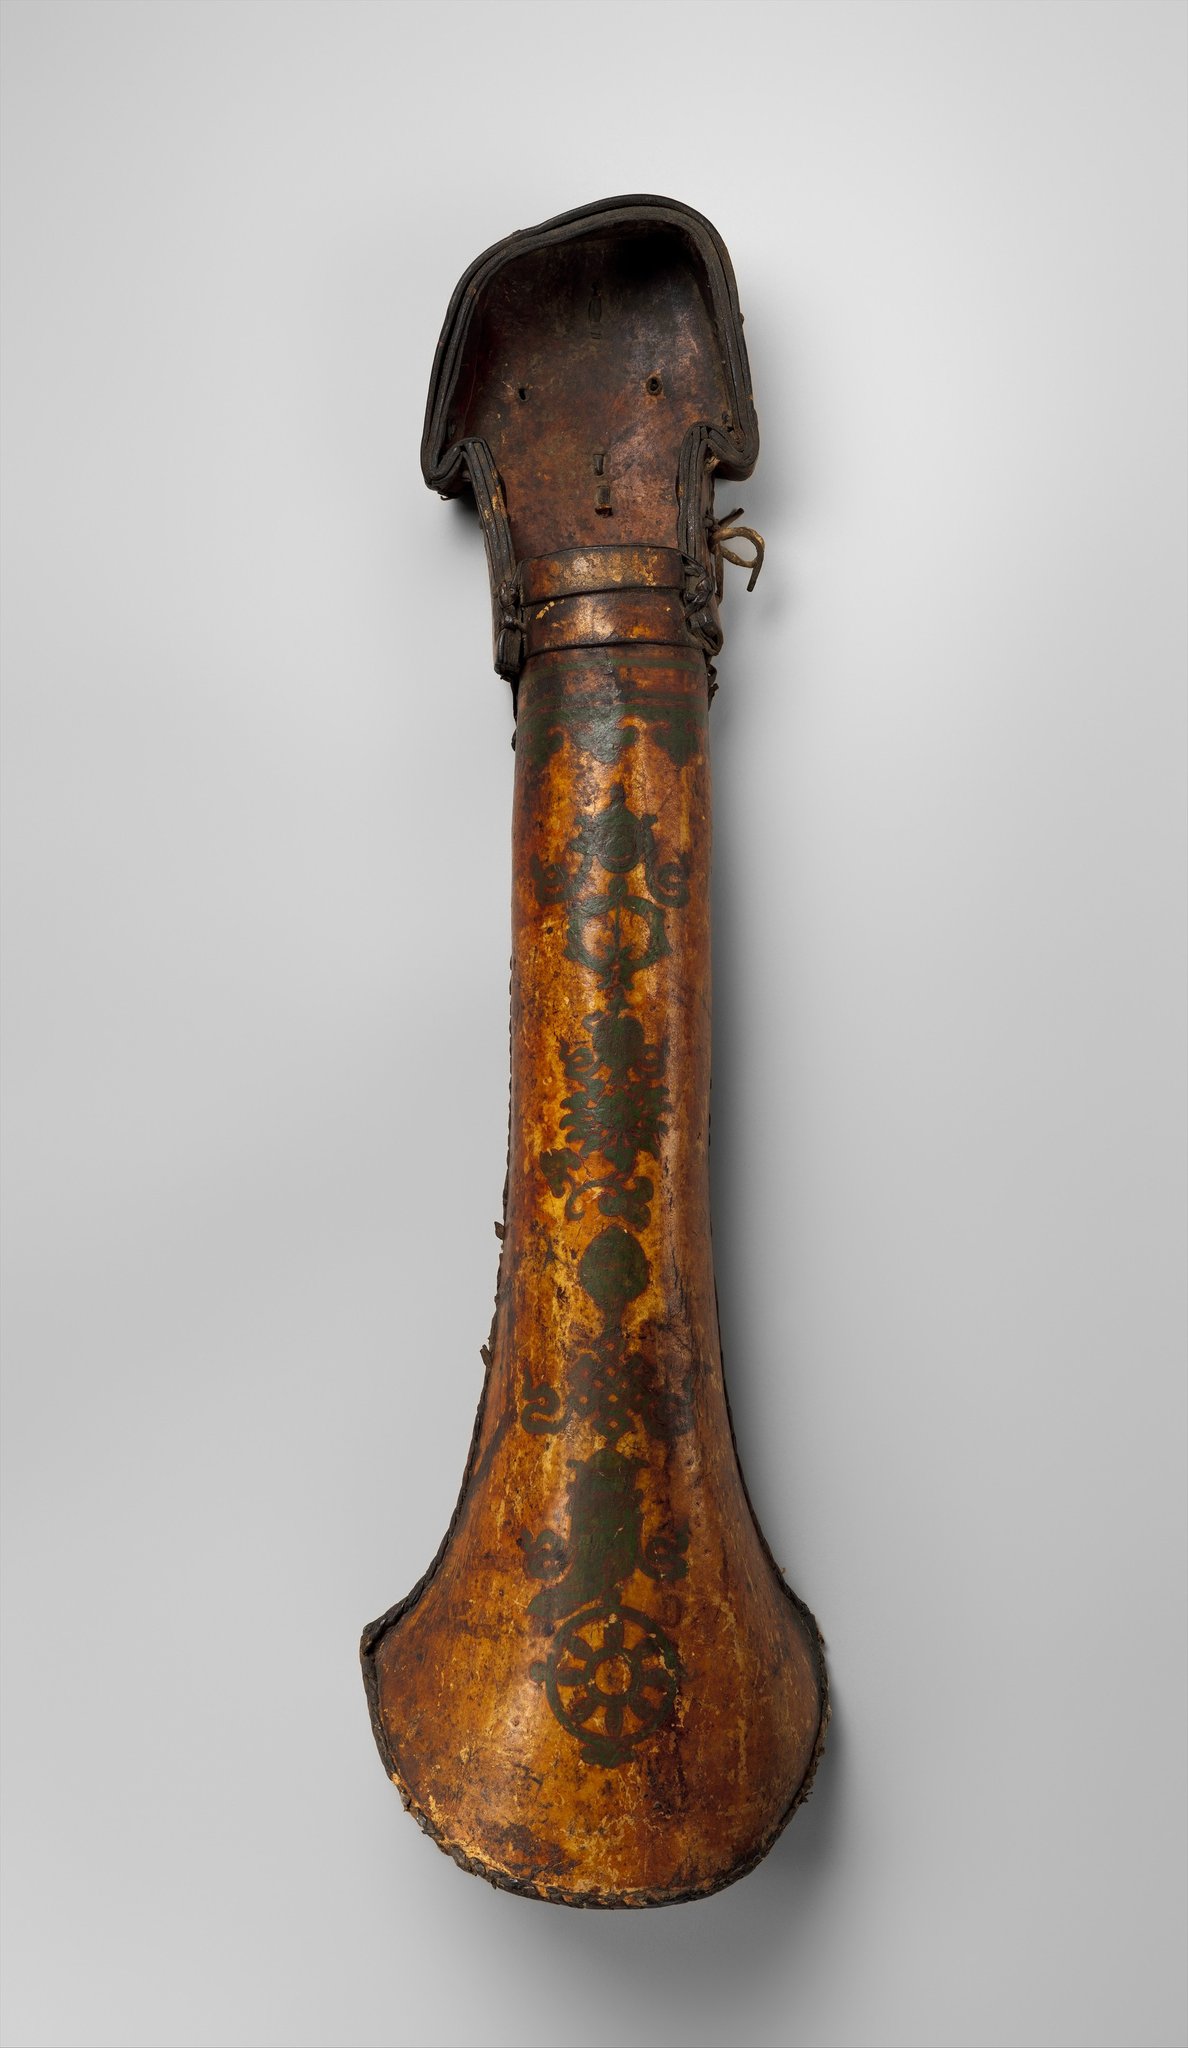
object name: quiver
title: Quiver Decorated with the Eight Auspicious Symbols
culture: mongolian or tibetan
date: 1301-1600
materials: leather, pigment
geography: tibet